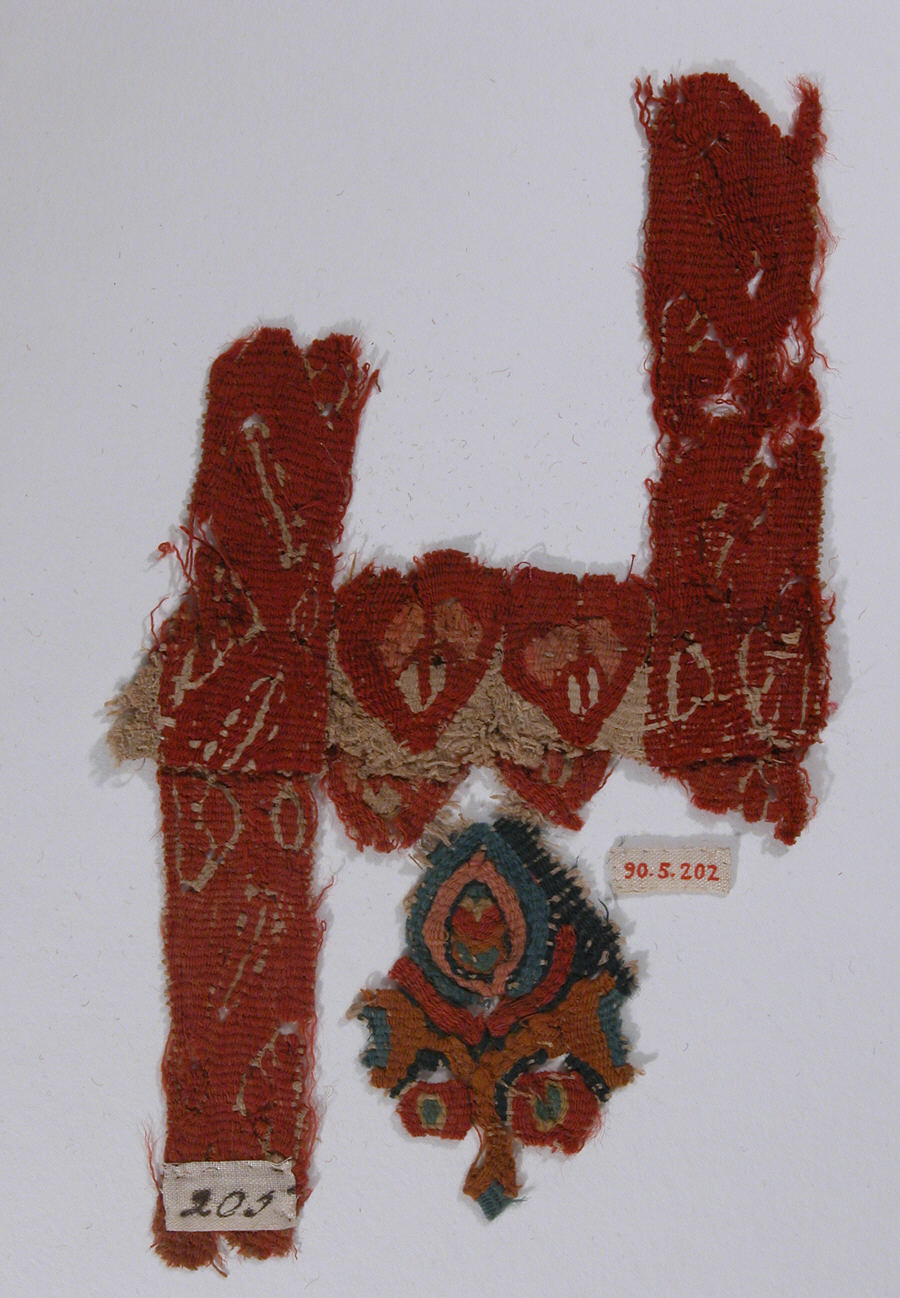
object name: textile fragment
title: Fragment of a Tunic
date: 501-700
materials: linen, wool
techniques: weave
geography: egypt